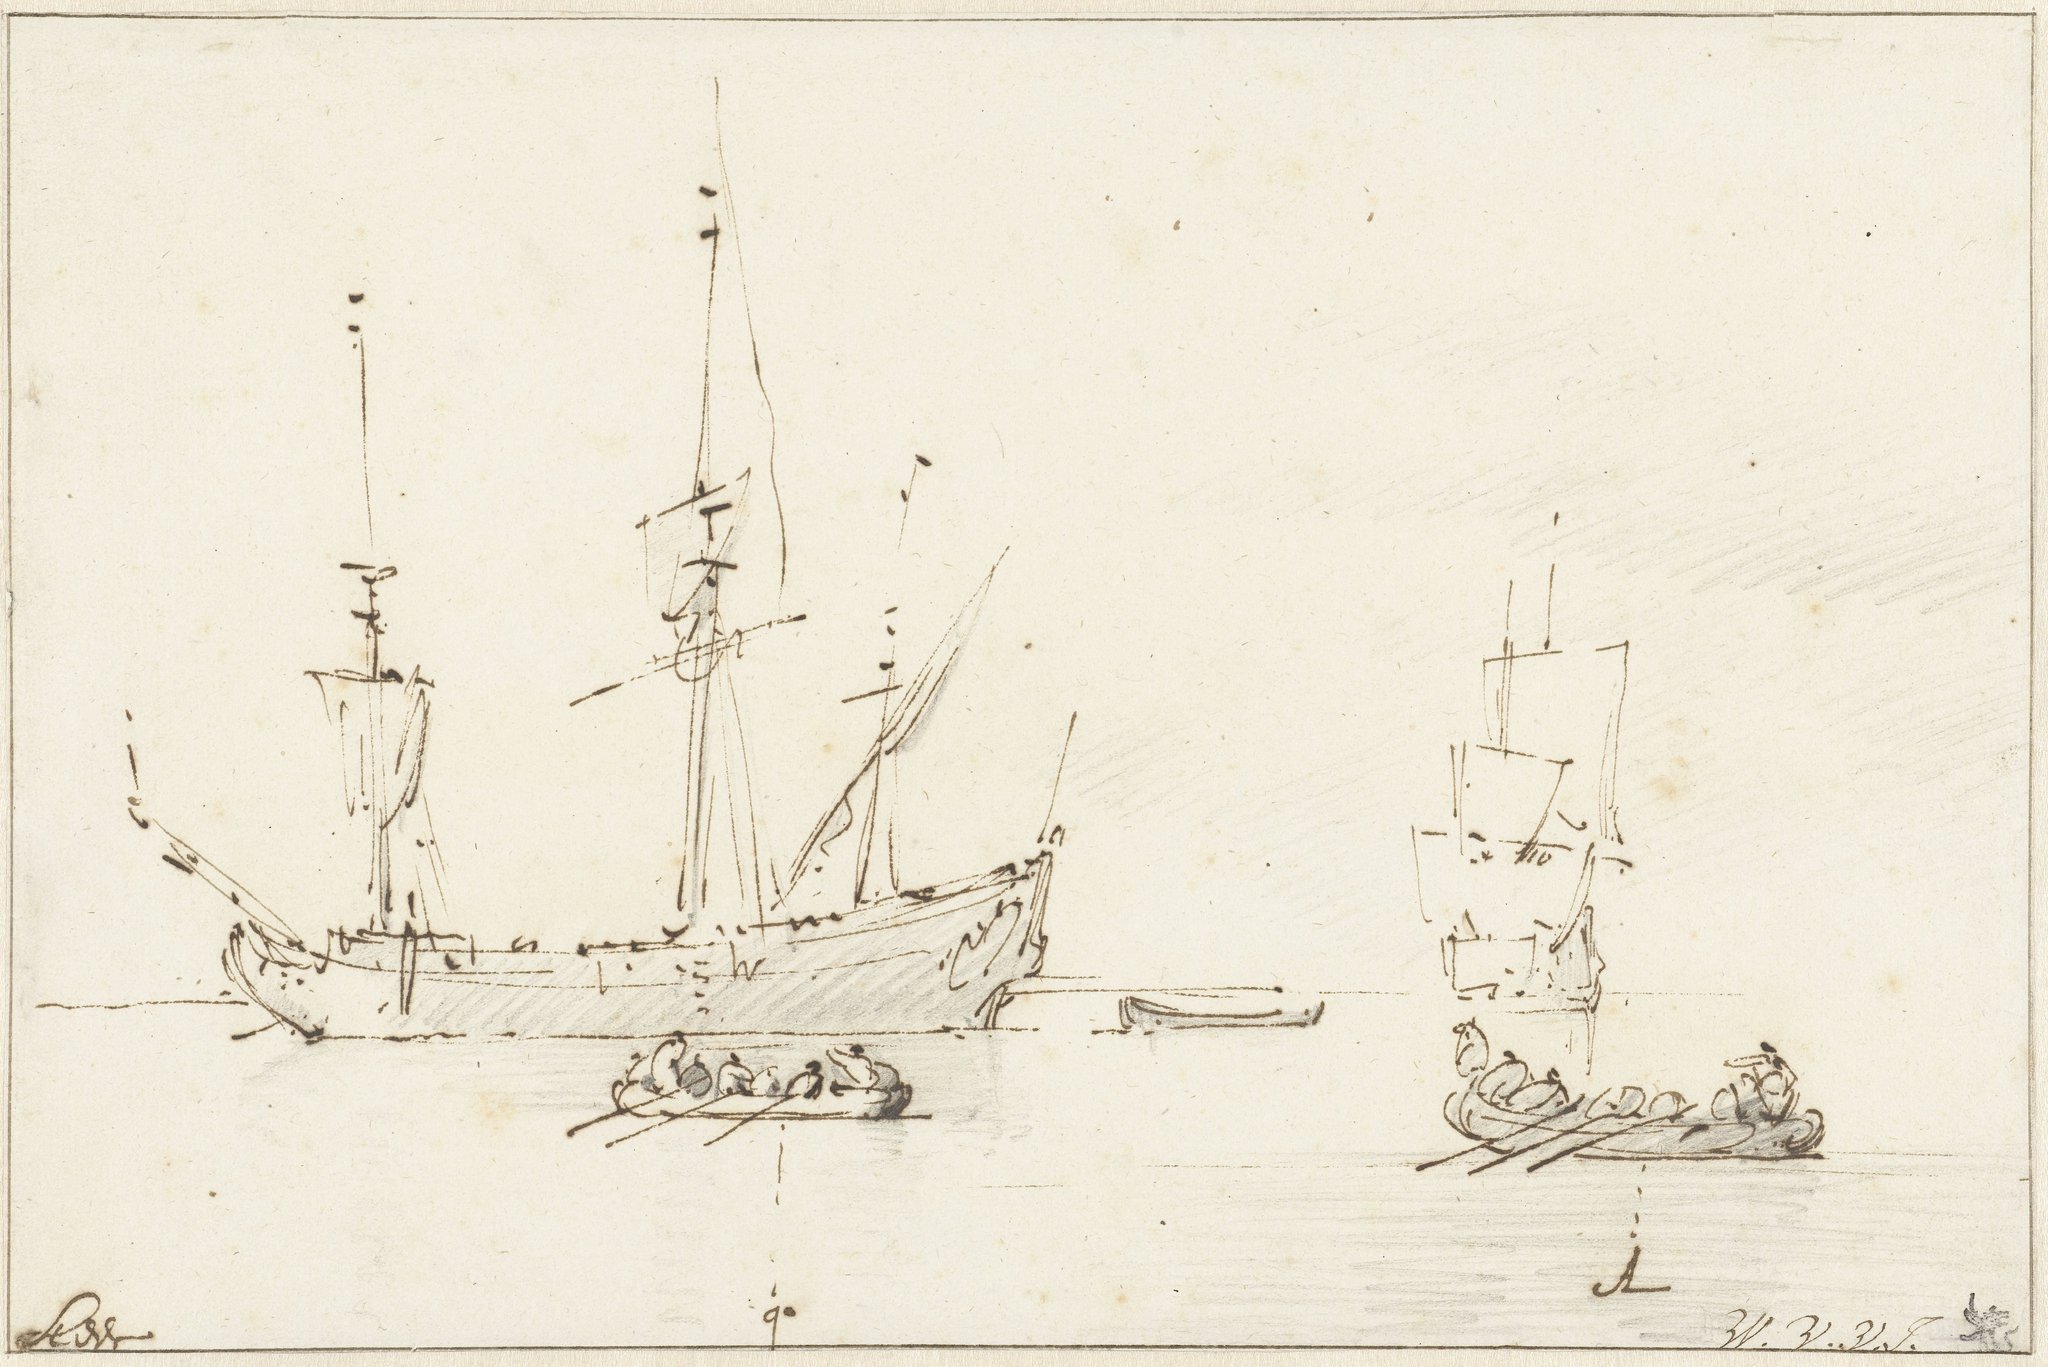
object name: drawing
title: Twee roeiboten varen in de richting van een koopvaardijschip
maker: willem van de velde (ii)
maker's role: draughtsman, painter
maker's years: 1633-1707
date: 1643-1707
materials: ink, paper, pencil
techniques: pen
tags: rowing-boat, canoe, etc., sea (seascape), ship in the roads, roadstead